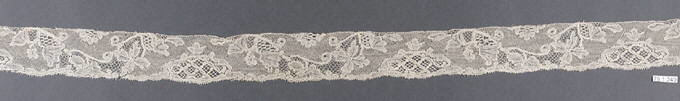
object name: strip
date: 1701-1800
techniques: lace